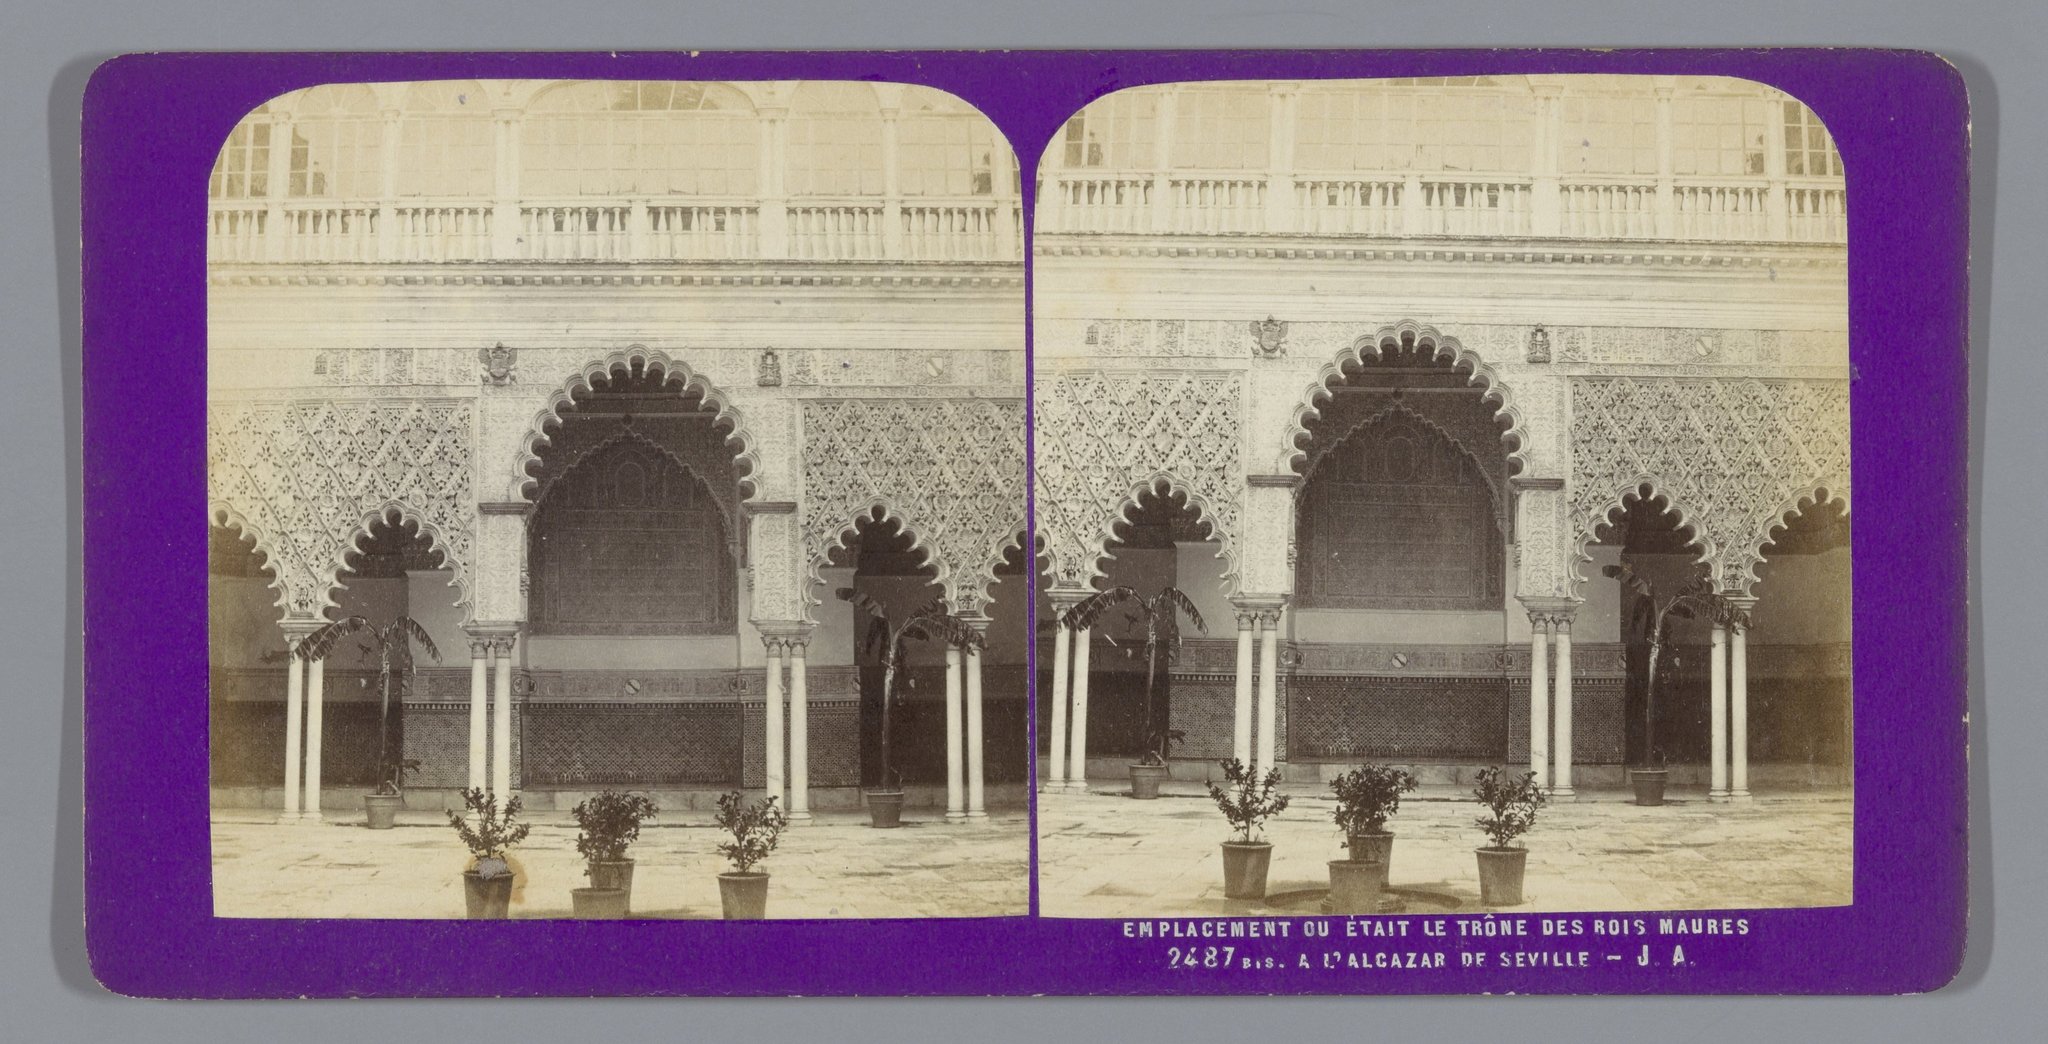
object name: stereograph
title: Gezicht op een nis bedoeld voor een troon in het Alcazar in Sevilla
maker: jean andrieu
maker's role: fotograaf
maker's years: 1816-1872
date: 1862-1876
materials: cardboard, photographic support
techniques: albumen print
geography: royal palace of seville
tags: arch, archivolt ~ architecture, courtyard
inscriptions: number: ‘2487 Bis.’